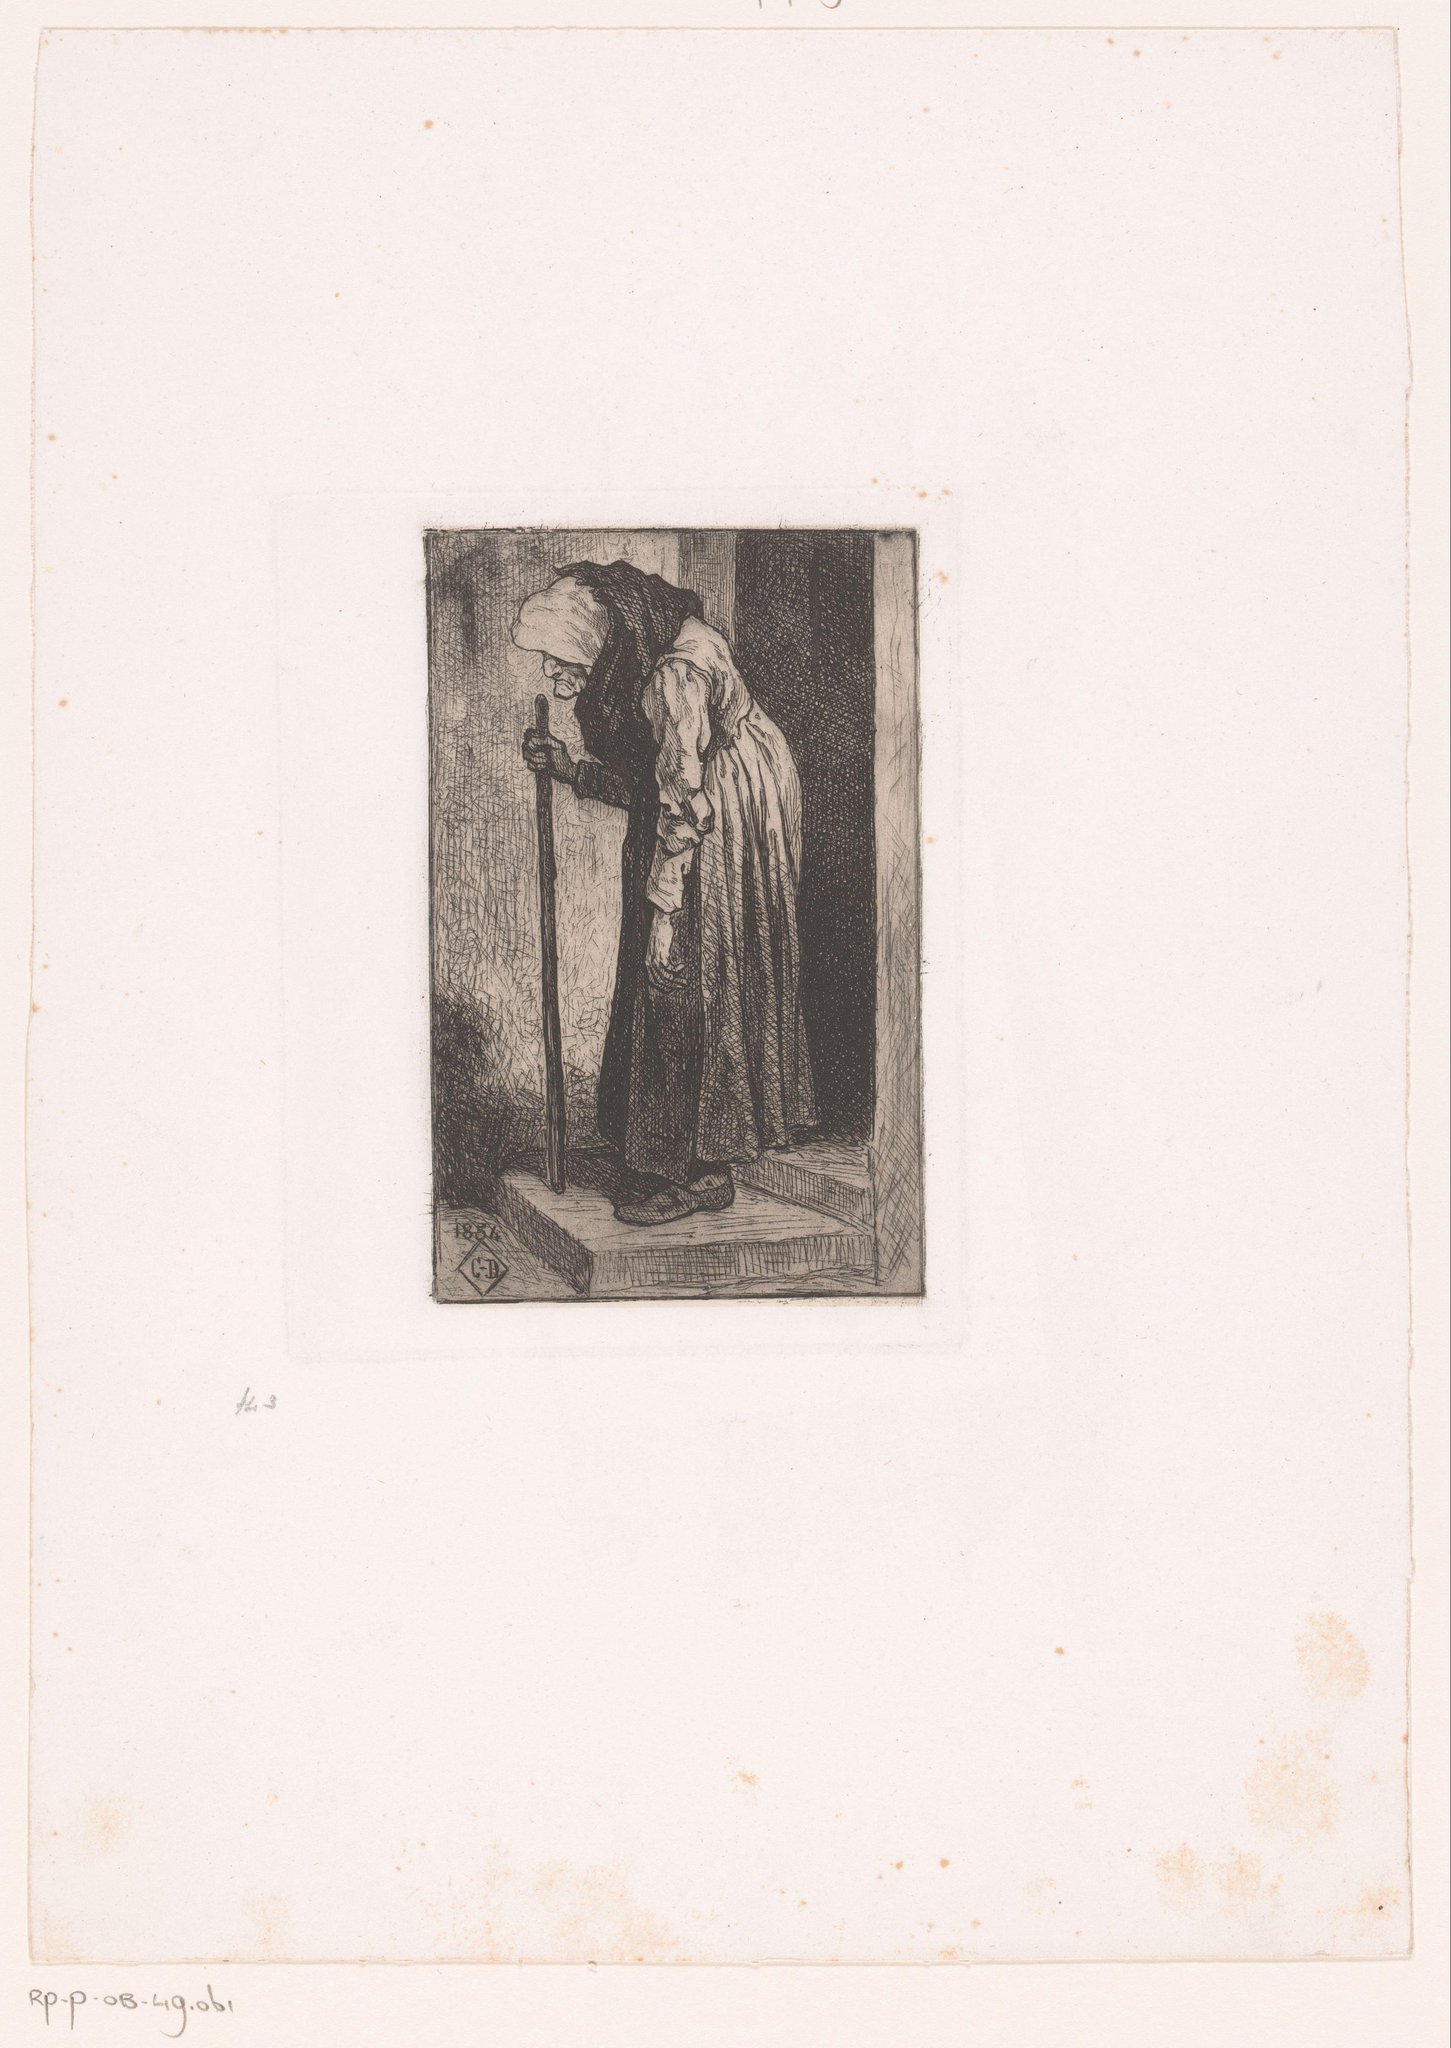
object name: print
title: Oude vrouw met stok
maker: charles de groux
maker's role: painter, print maker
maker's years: 1825-1870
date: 1854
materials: paper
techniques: etching, intaglio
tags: walking-stick, staff, old woman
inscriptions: collector's mark: Lugt 2228